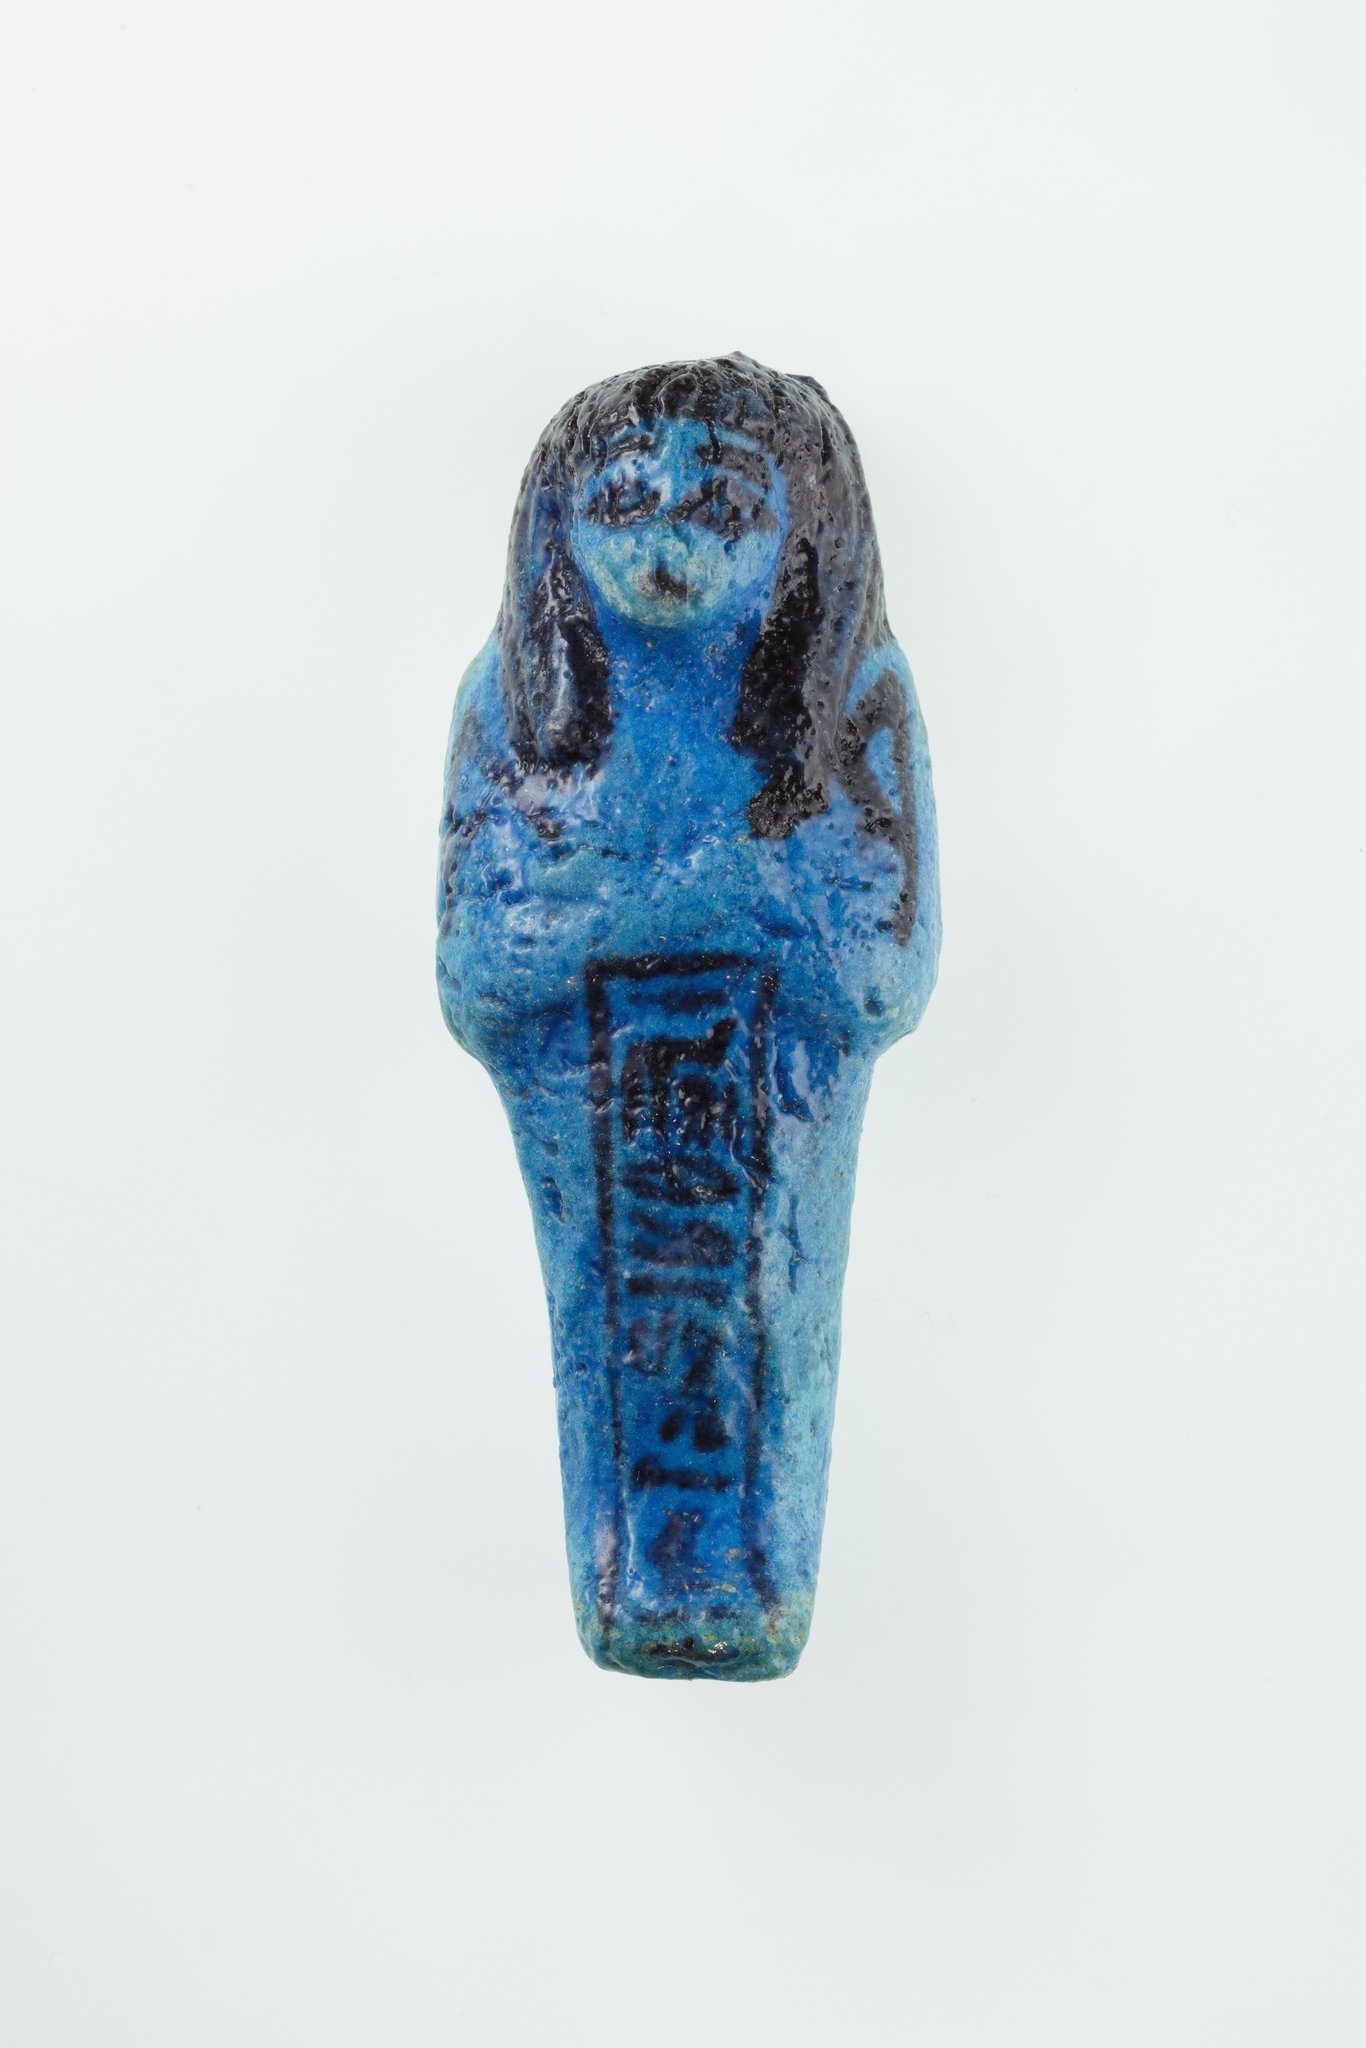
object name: shabti, worker, nauny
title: Worker Shabti of Nauny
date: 1050 BCE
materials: faience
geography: egypt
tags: hieroglyphs